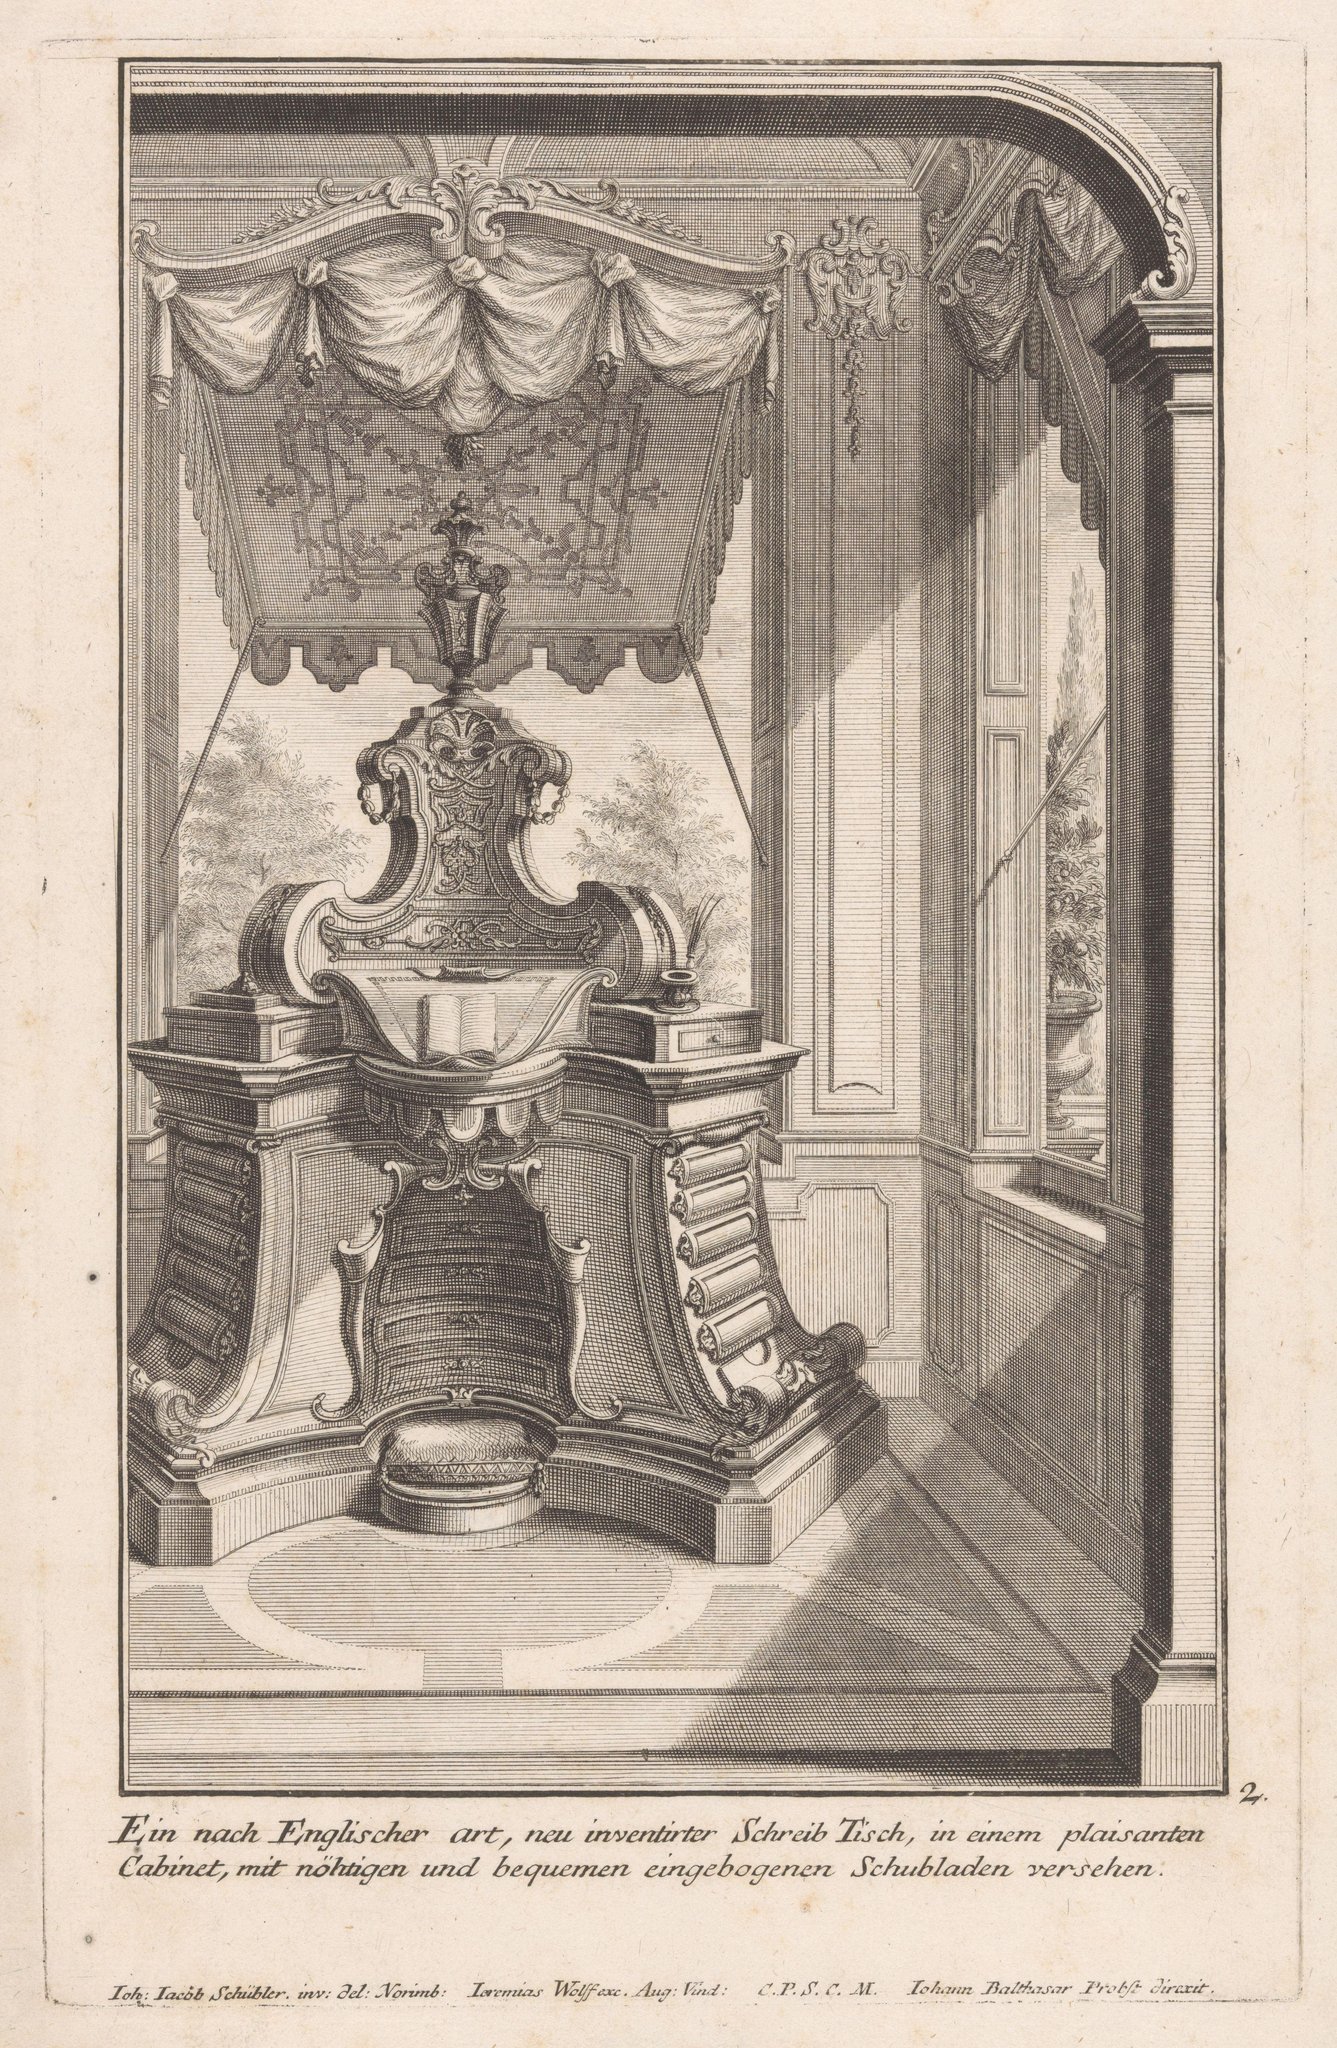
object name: ornament print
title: Johann Jacob Schüblers Vierdte Ausgab seines vorhabenden Wercks, Worinnen vorgestellet werden Neu-inventirte Schreib-Tische (...)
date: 1709-1724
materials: paper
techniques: engraving, etching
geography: augsburg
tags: writing-table, writing-desk, open window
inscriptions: collector's mark: Lugt 2228, collector's mark: Lugt 2760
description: Prent uit: Schübler, Johann Jacob. Erste [-Zwanzigste] Ausgabe seines vorhabenden Wercks (...). Augsburg: Wolf, erven Jeremias, [na 1724]